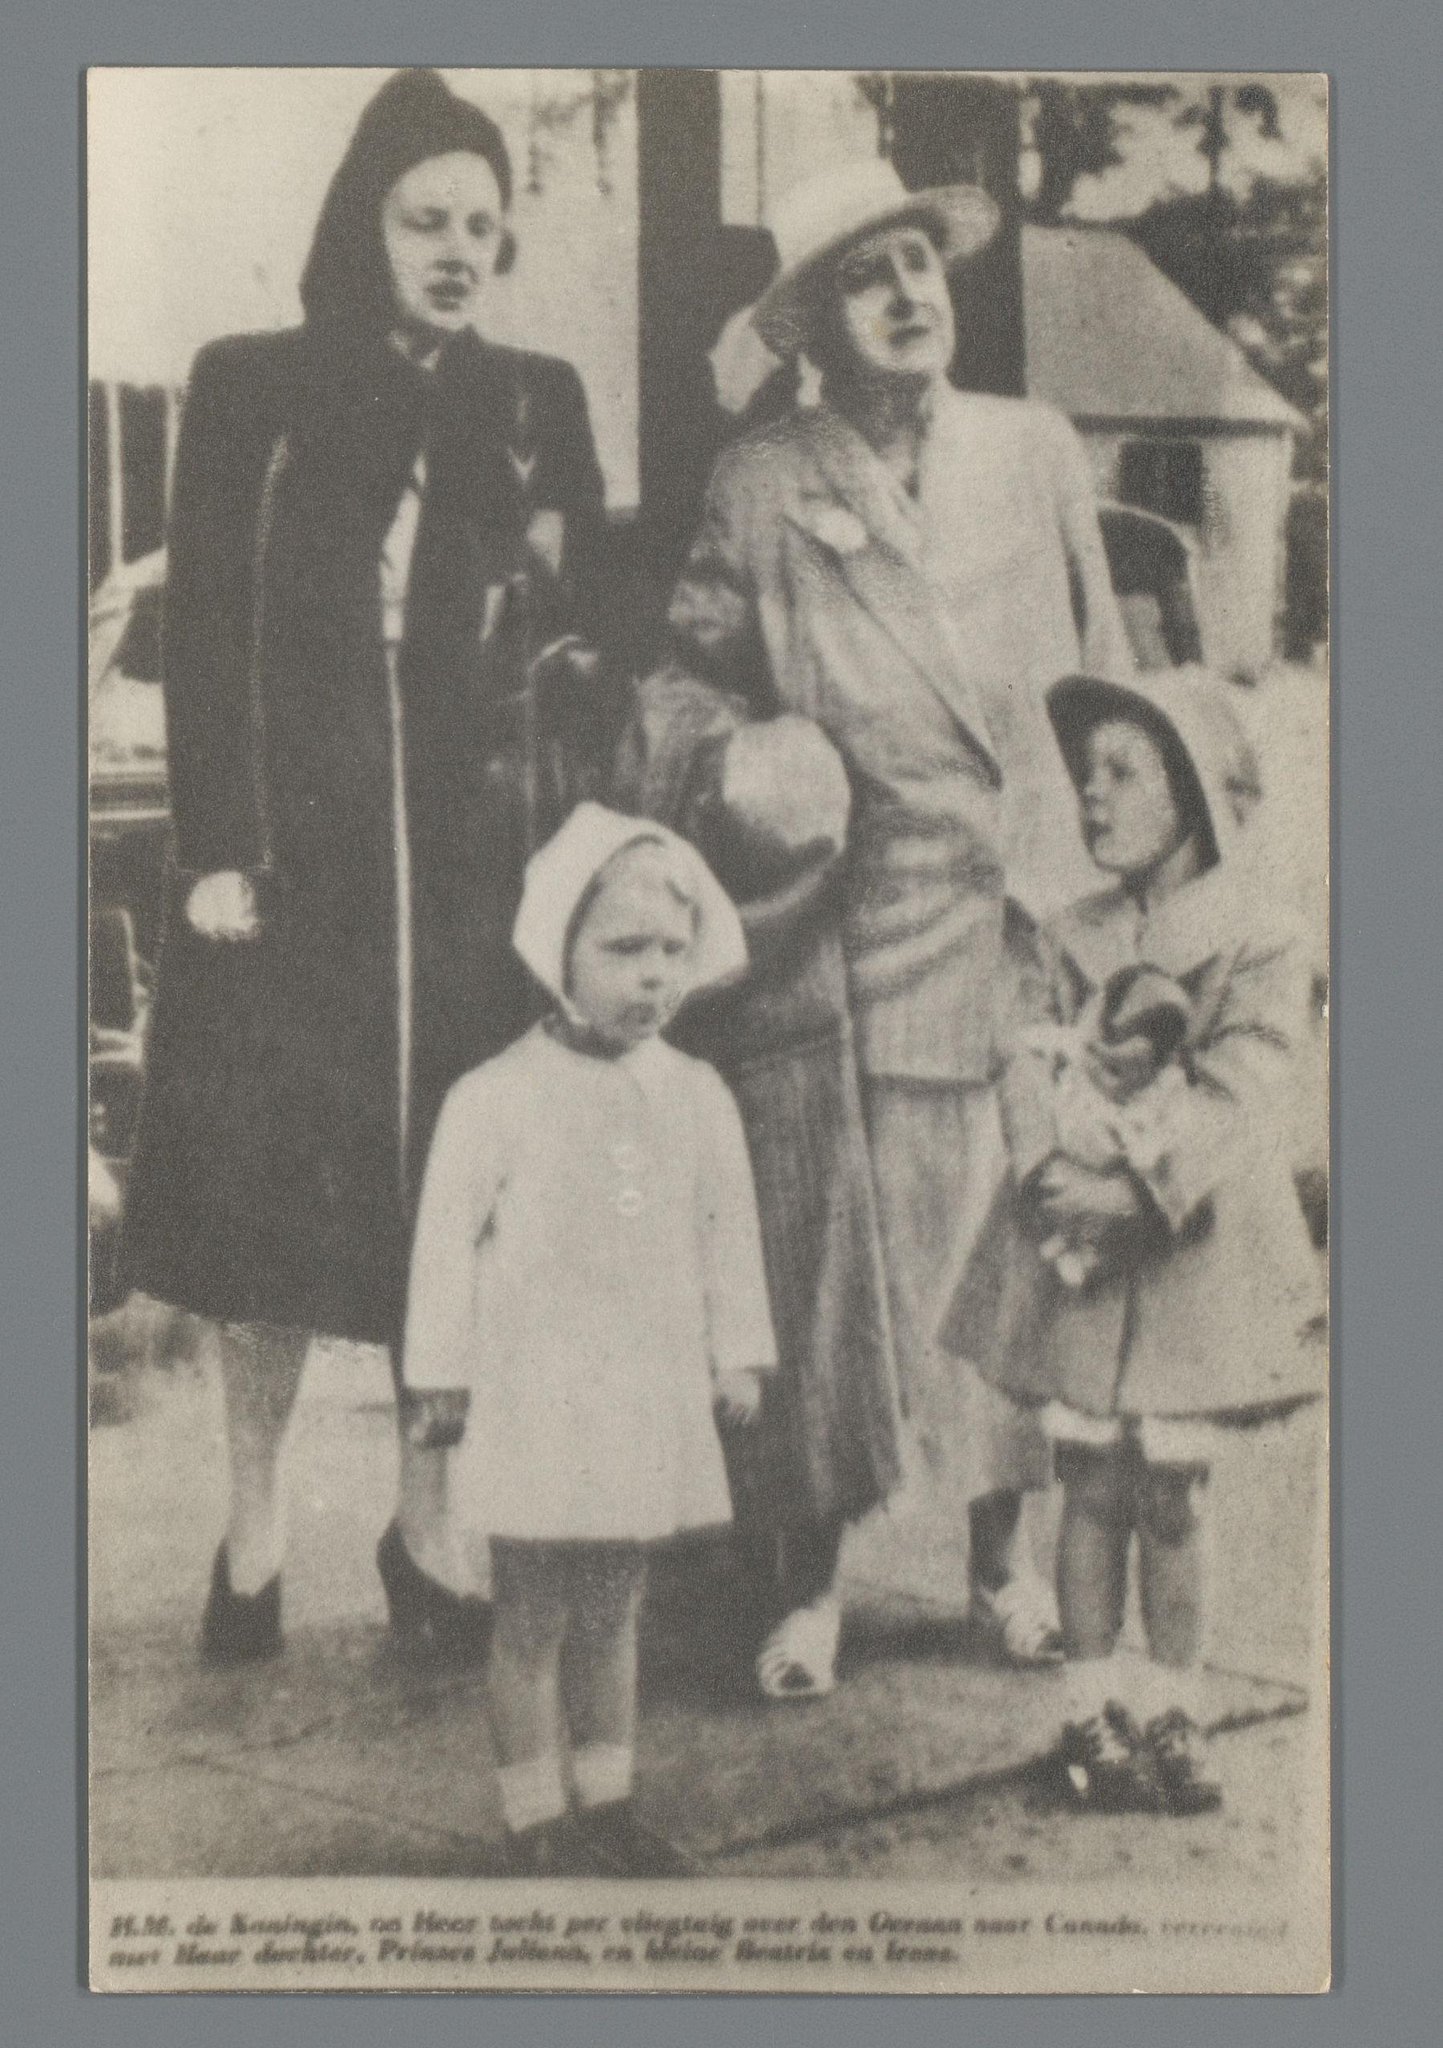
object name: reproduction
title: Fotoreproductie van een krantenfoto van koningin Wilhelmina der Nederlanden met haar dochter kroonprinses Juliana en kleindochters prinses Beatrix en prinses Irene in Londen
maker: Anonymous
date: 1944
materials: paper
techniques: gelatin silver print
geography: london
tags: print maker, wilhelmina of the netherlands, beatrix (koningin der nederlanden), the hague, juliana of the netherlands, crown princess, queen, princess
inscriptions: inscription: ‘H.M. de Koningin na Haar tocht per vliegtuig over den Oceaan naar Canada […]/ met Haar dochter, Princes Juliana, en […] Beatrix en Irene.’, inscription: ‘Mimosa’